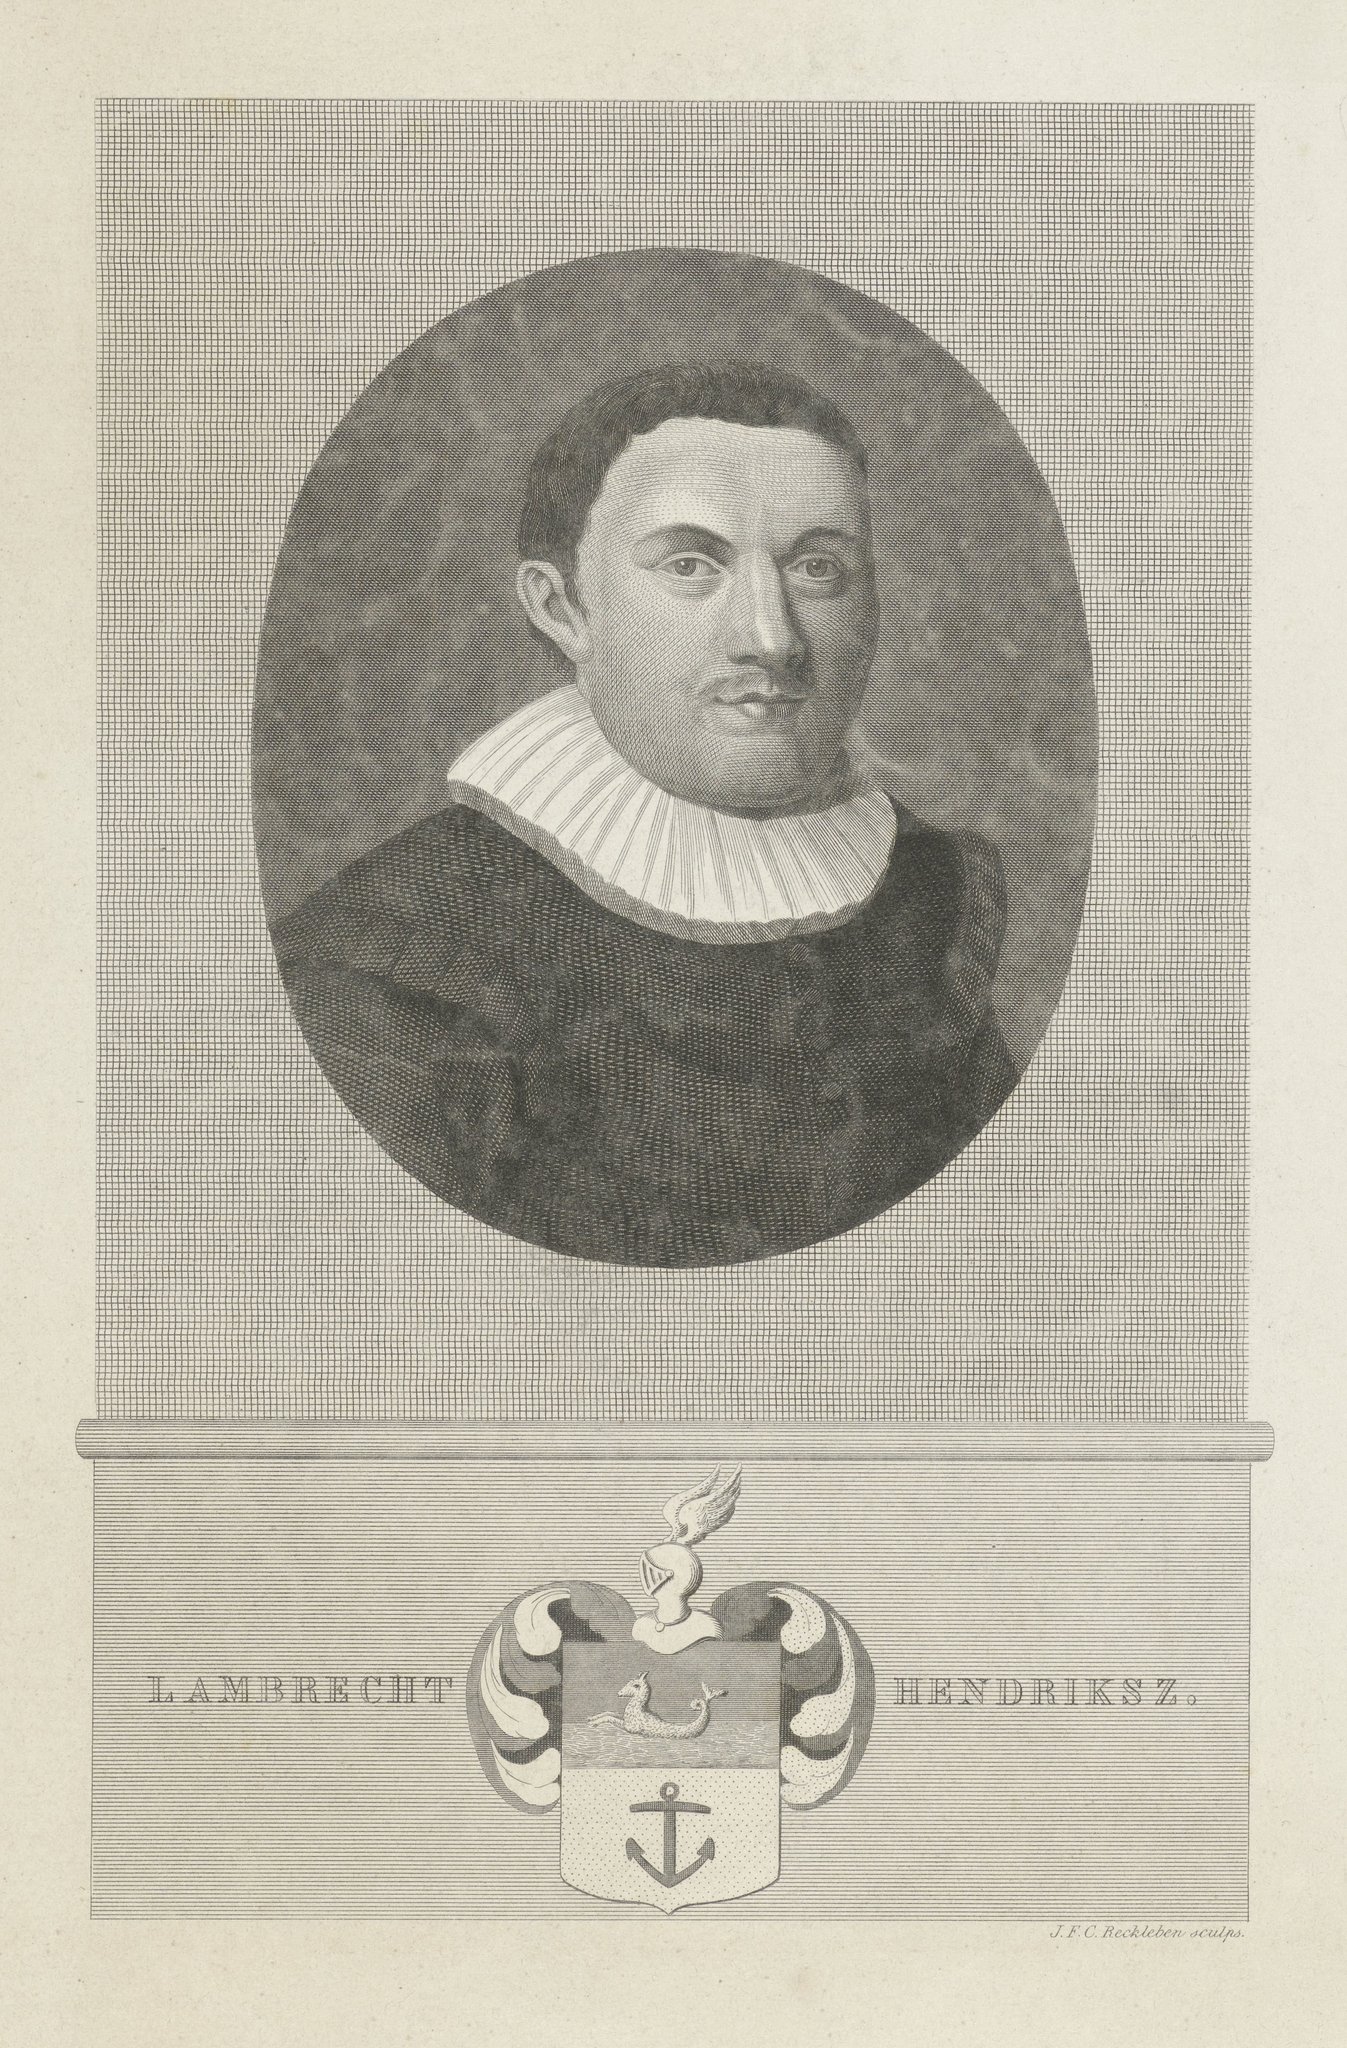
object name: print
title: Portret van Lambrecht Hendriksz. Verhouven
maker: jan frederik christiaan reckleben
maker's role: print maker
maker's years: 1819-1879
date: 1858-1860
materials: paper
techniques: engraving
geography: amsterdam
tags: brielle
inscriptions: collector's mark: Lugt 2228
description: Illustratie in: Arend, Johannes Pieter. Algemeene geschiedenis des vaderlands van de vroegste tijden tot op heden. 5 delen, Amsterdam: Schleijer, J.F. 1840-1884, dl. 3.3, p. 639.